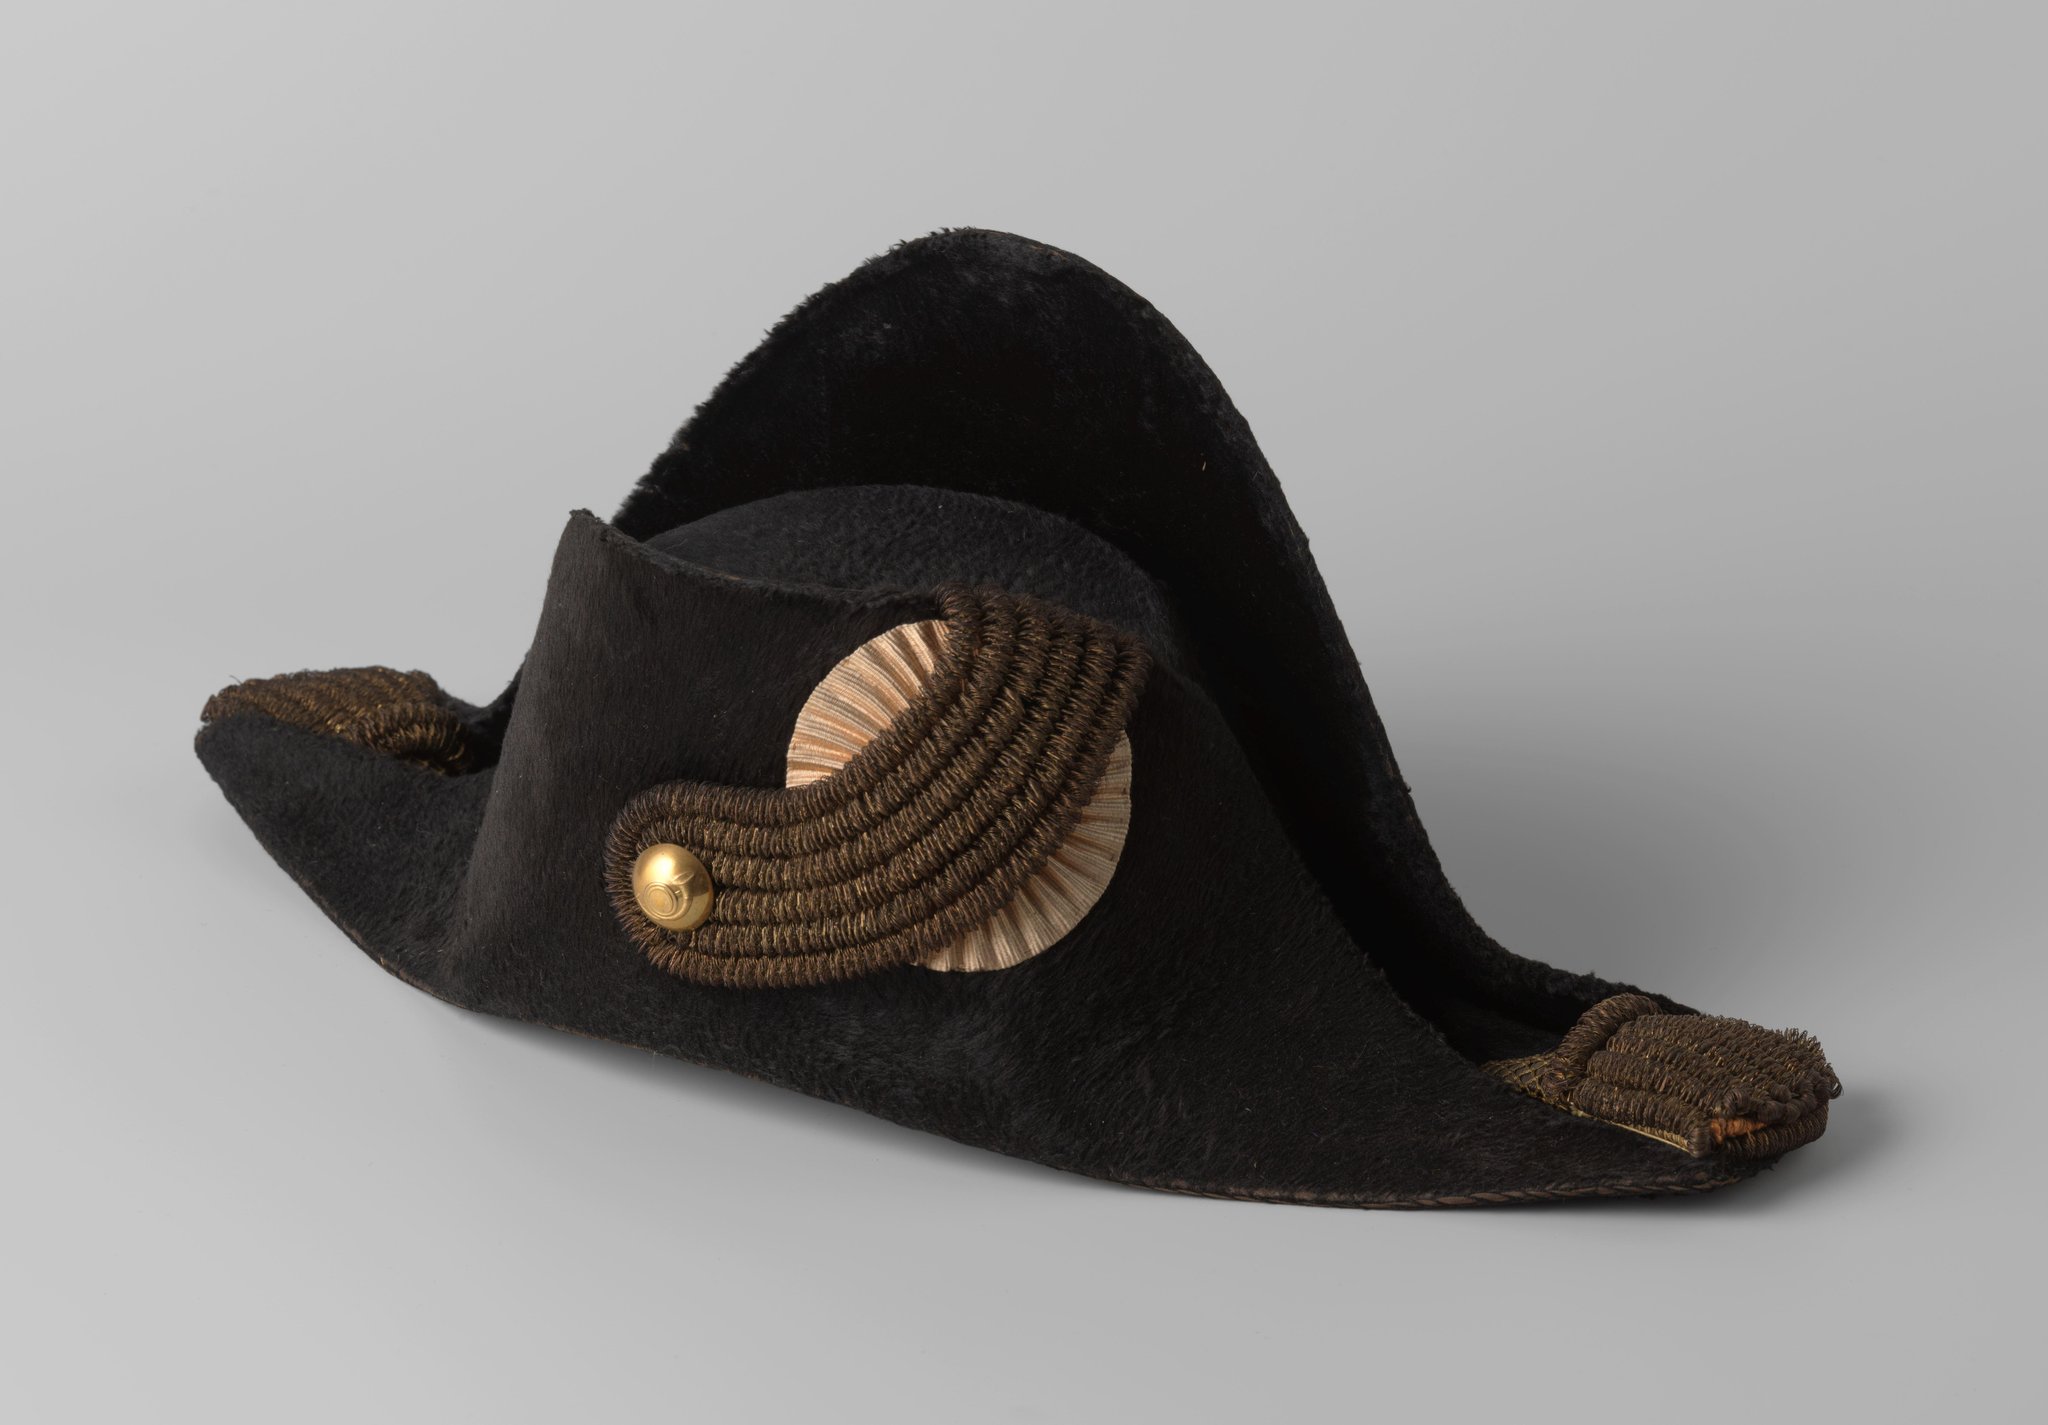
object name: uniform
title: Steek met oranje kokarde en knoop waarop een jachthoorn, behorende bij het galapak van houtvester Antonie Brugmans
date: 1824-1843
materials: felt, leather, metal, textile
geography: amsterdam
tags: kapitein, houtvester, antonie brugmans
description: Steek met oranje kokarde en knoop waarop een jachthoorn, behorende bij het galapak van houtvester Antonie Brugmans.